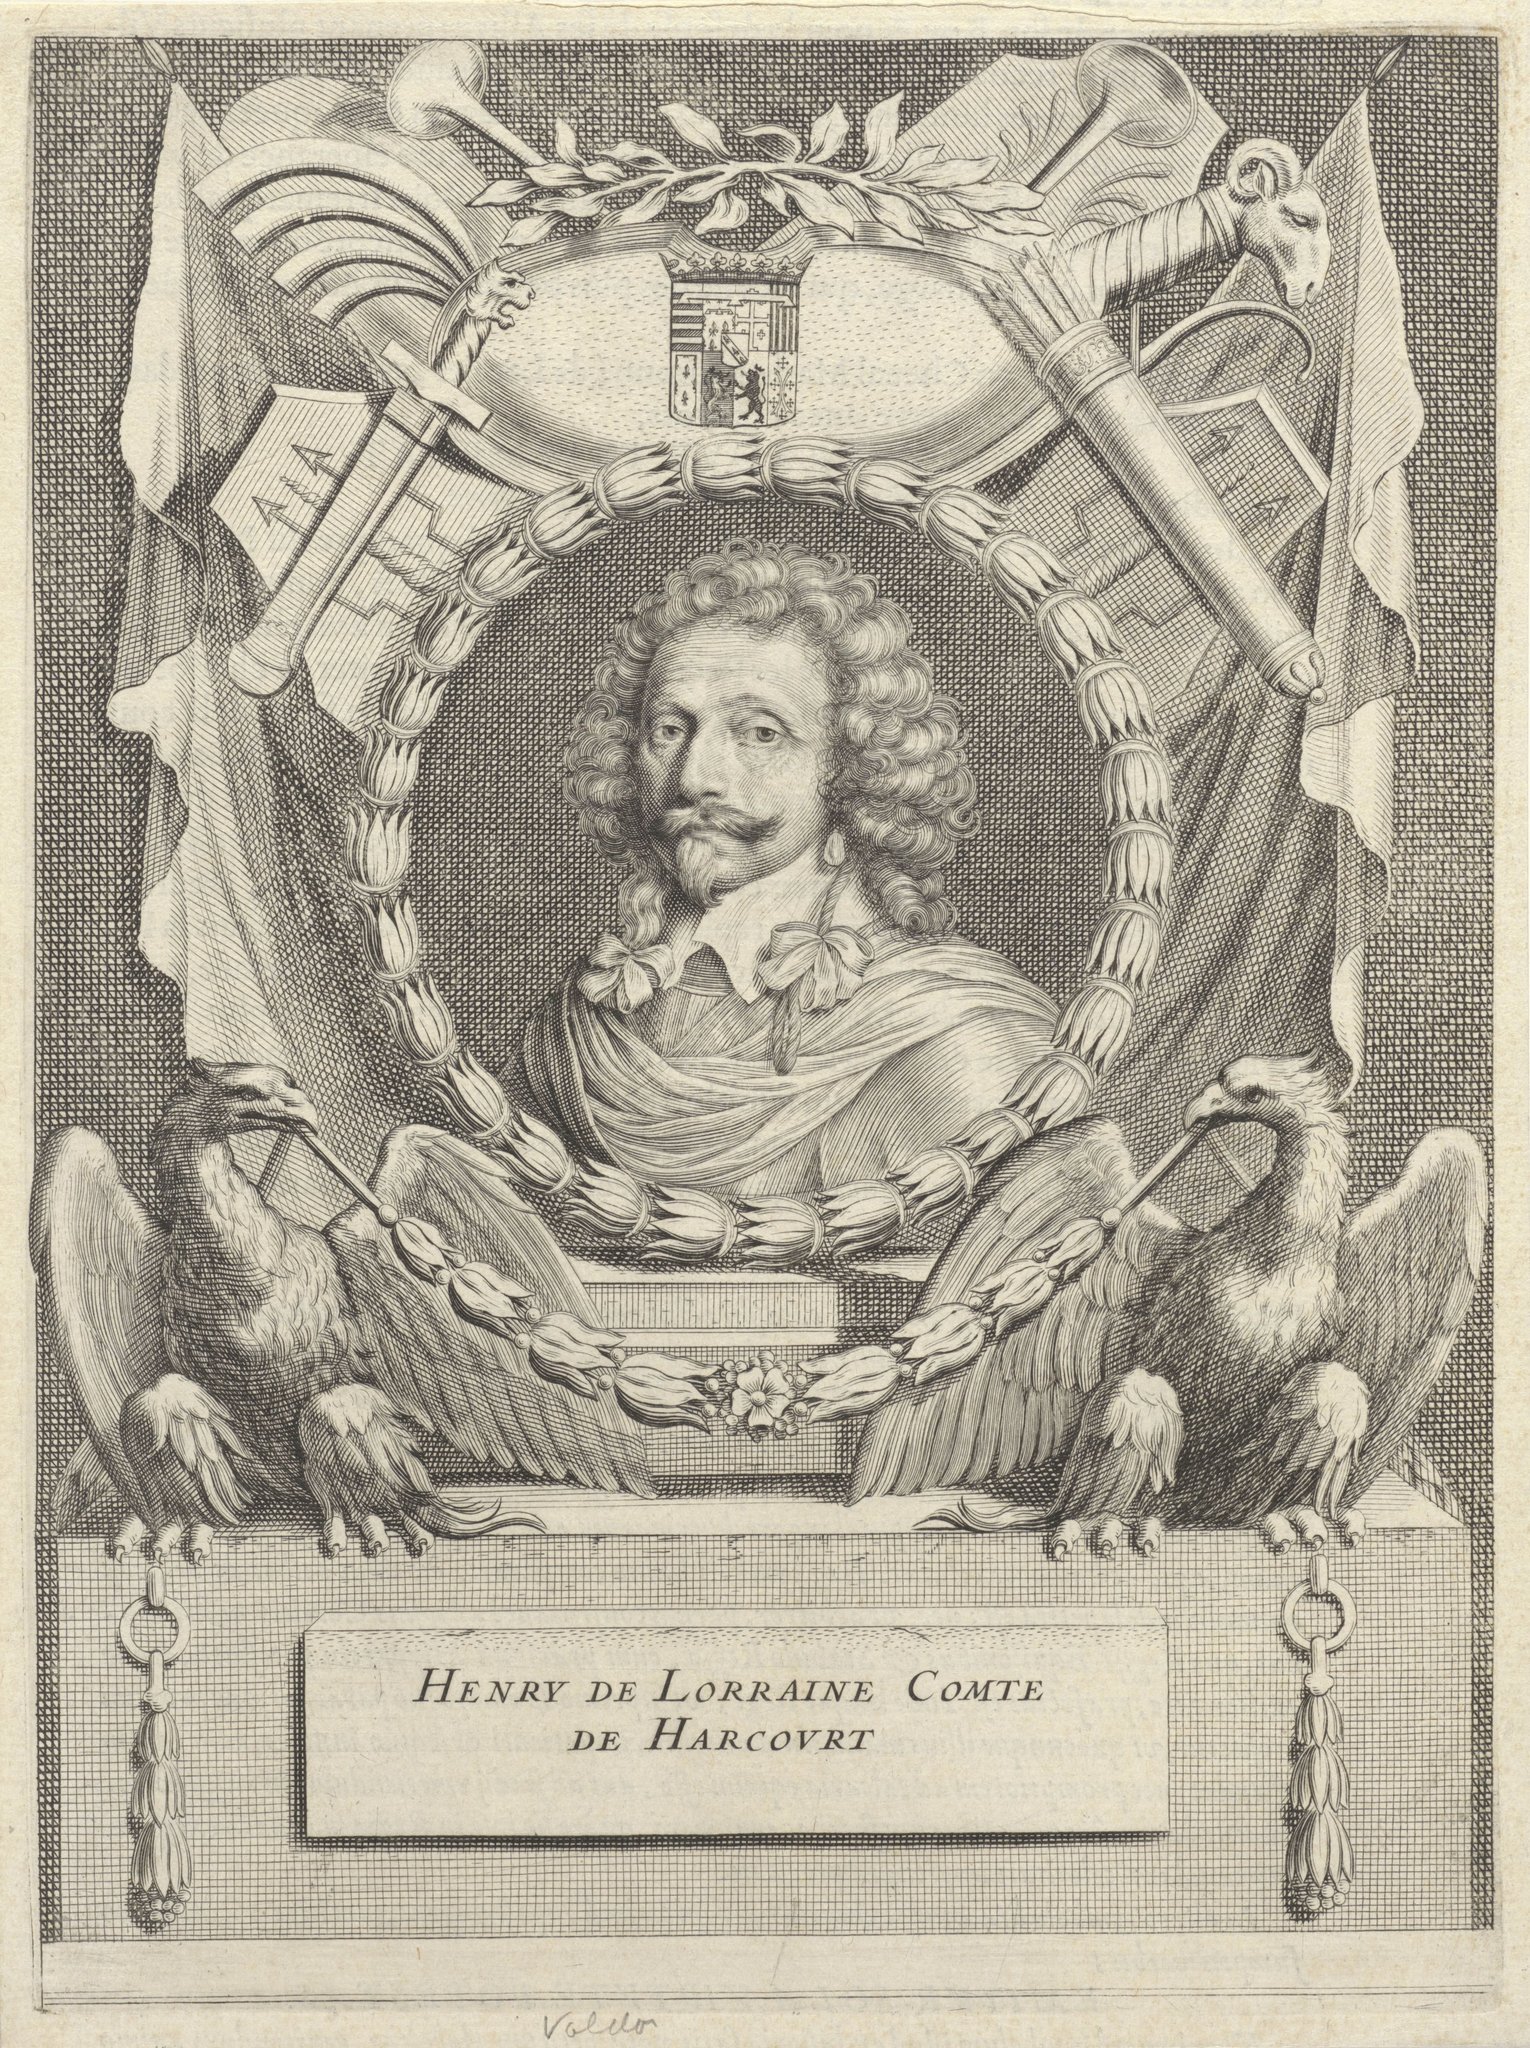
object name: book illustration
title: Portret van Henri de Lorraine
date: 1649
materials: paper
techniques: engraving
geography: paris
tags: lodewijk xiii (koning van frankrijk)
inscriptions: collector's mark: Lugt 2228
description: Boekillustratie in: Estienne, Henry. Devises des roys, princes et generaux d'armees qui ont assiste ou servy Louis le Juste combattant. In: Les Triomphes de Louis le Juste XIII. Parijs: A. Estienne, 1649.